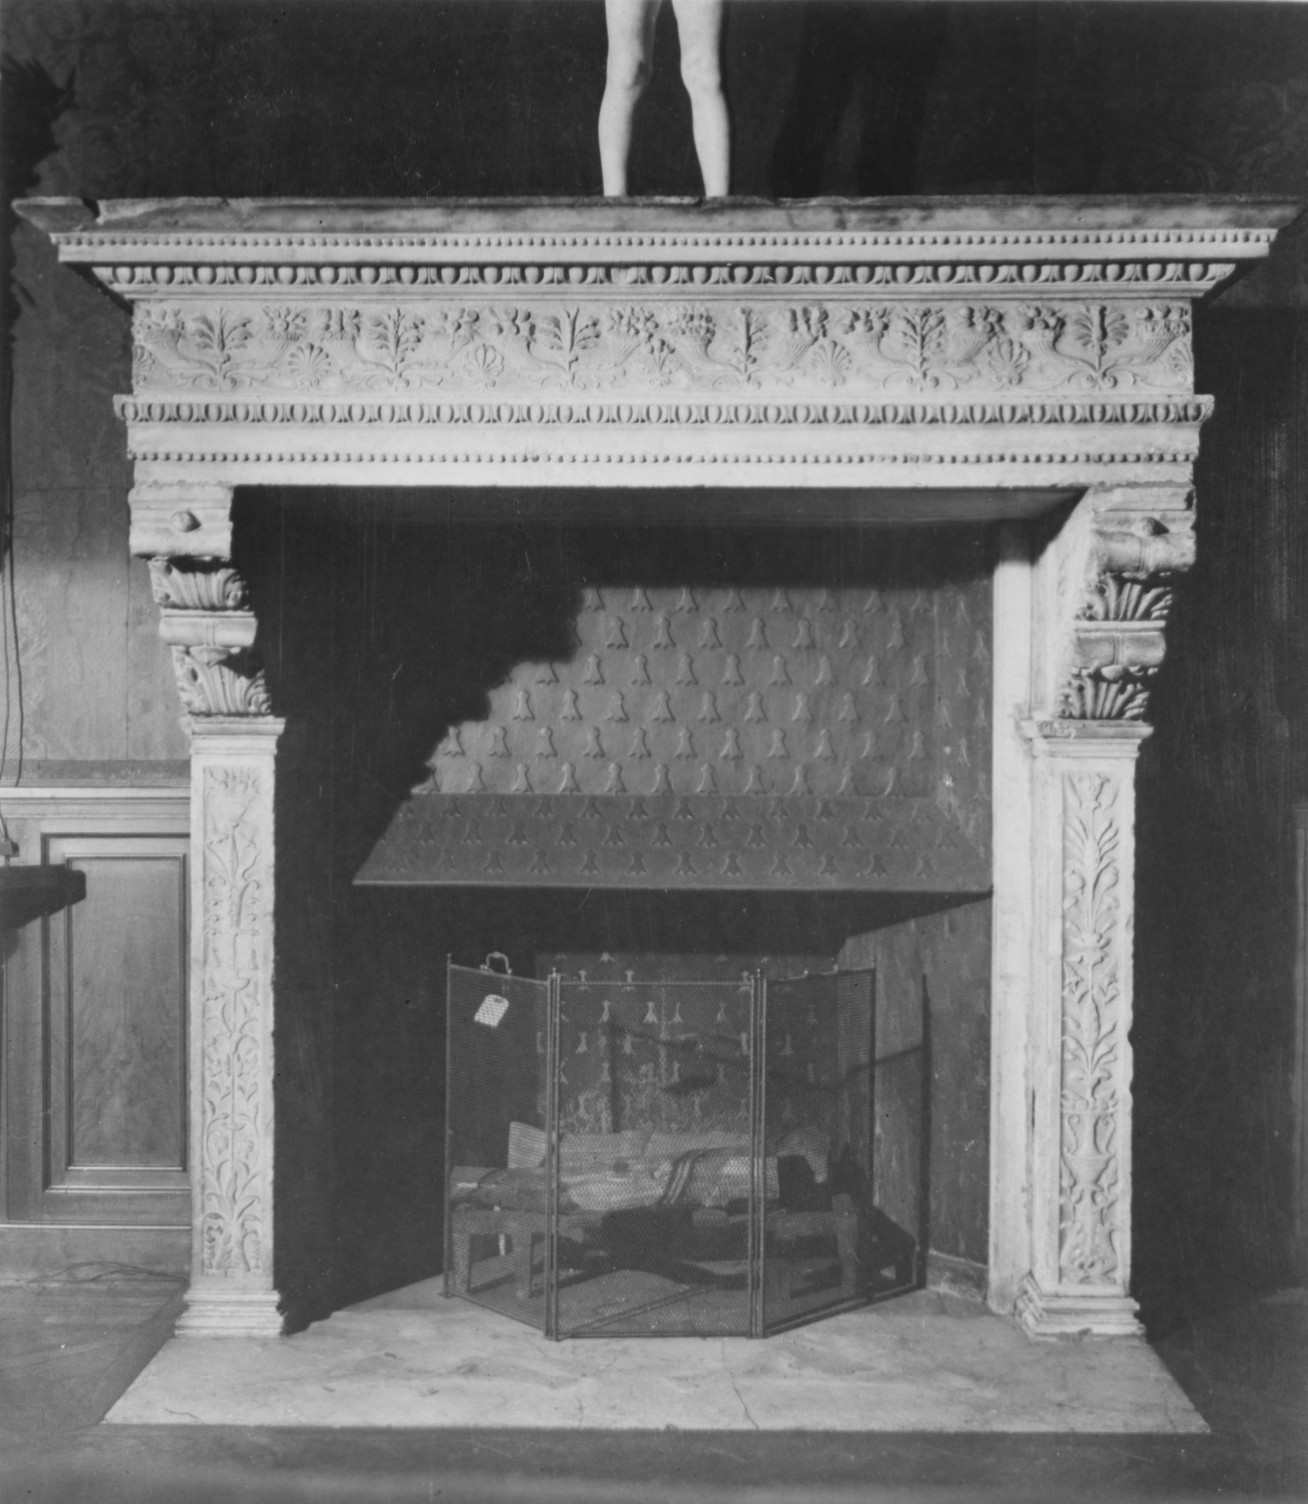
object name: mantel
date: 1467-1500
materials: marble